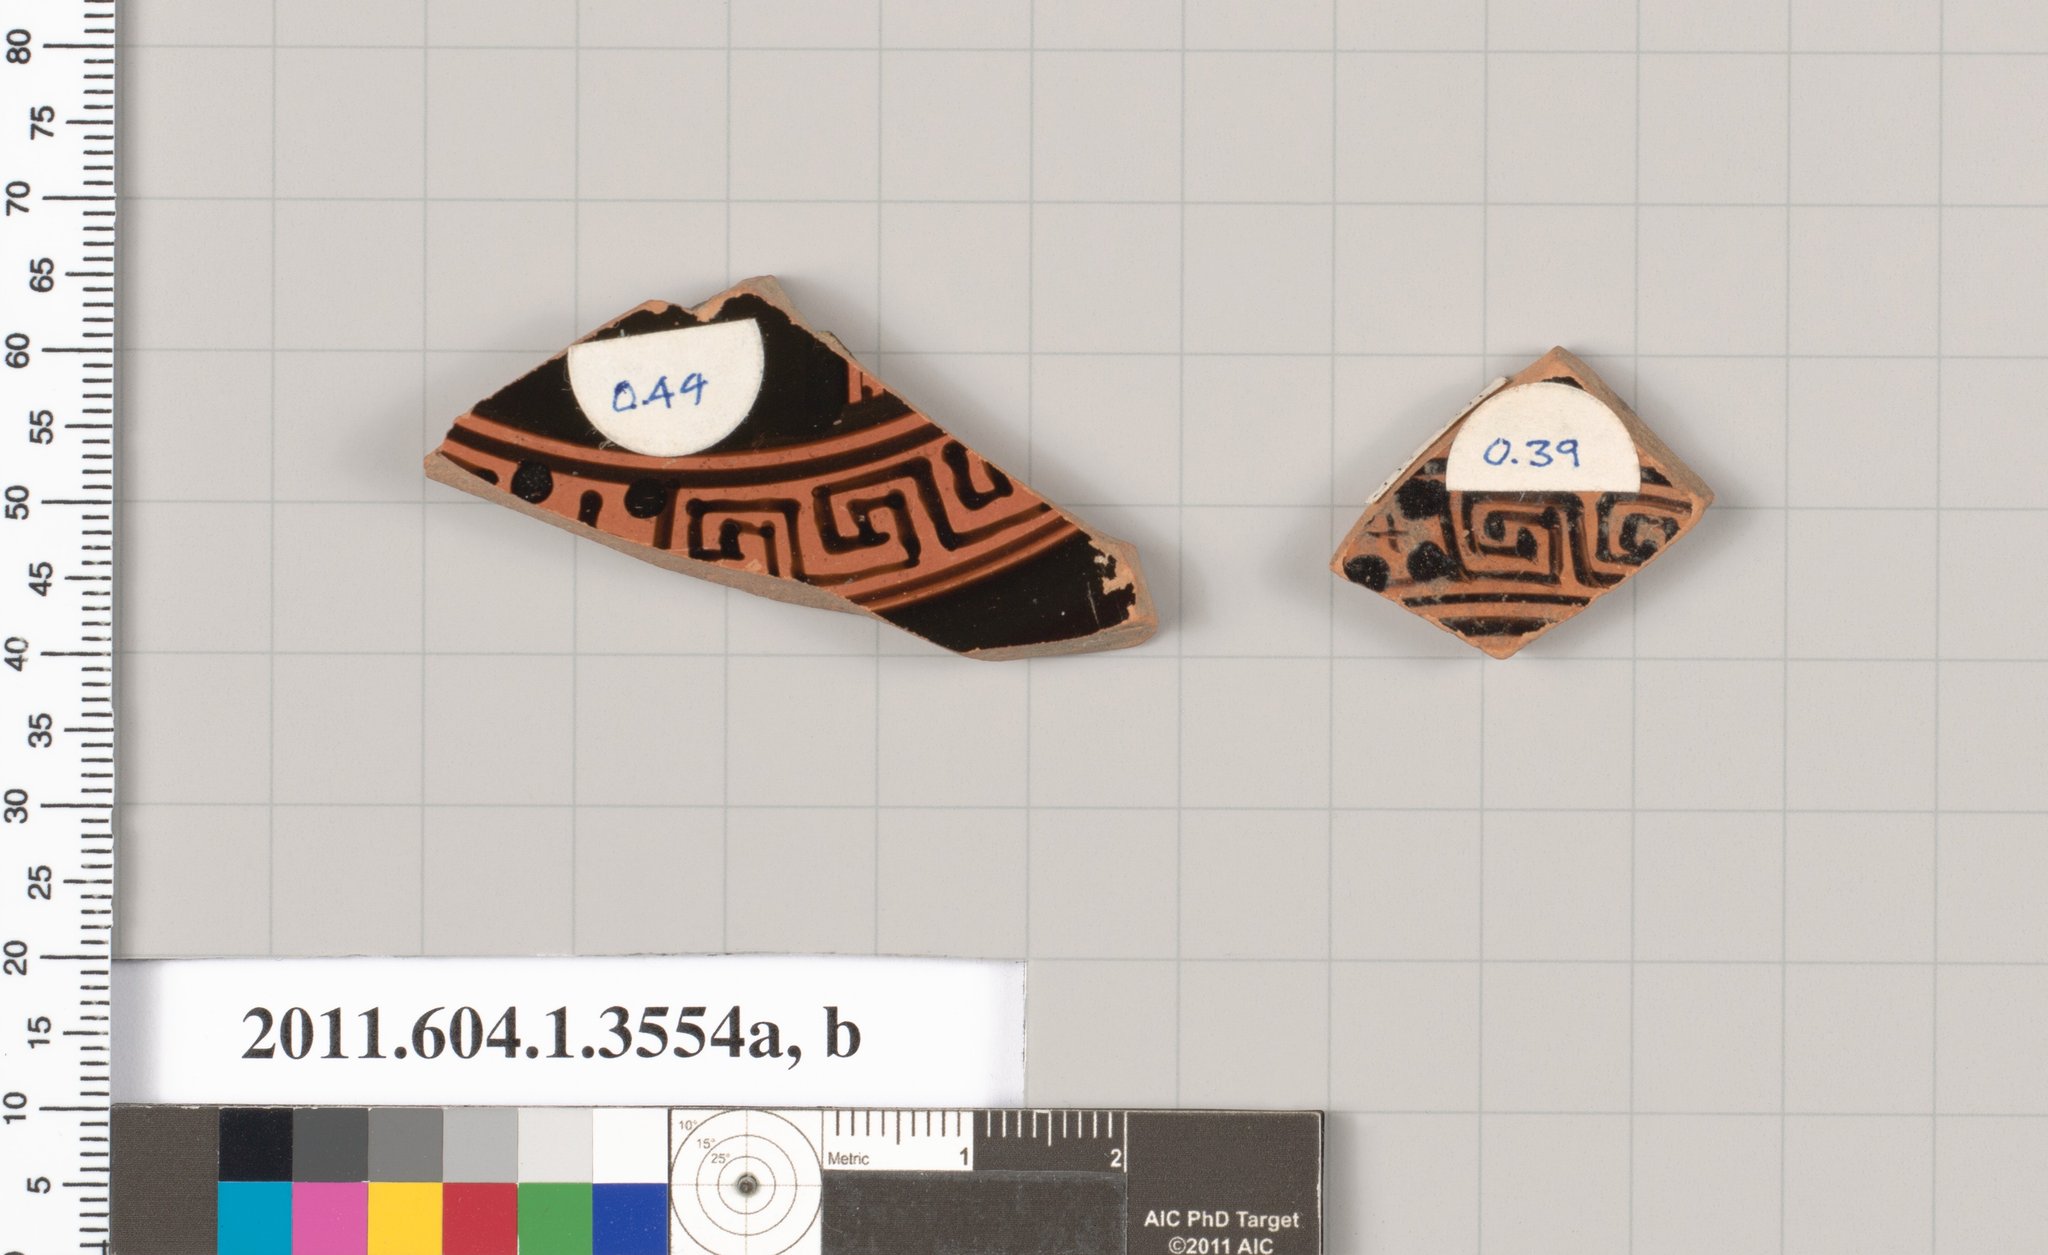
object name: kylix fragment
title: Terracotta fragments of kylikes (drinking cups)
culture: greek, attic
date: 475-451 BCE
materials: terracotta